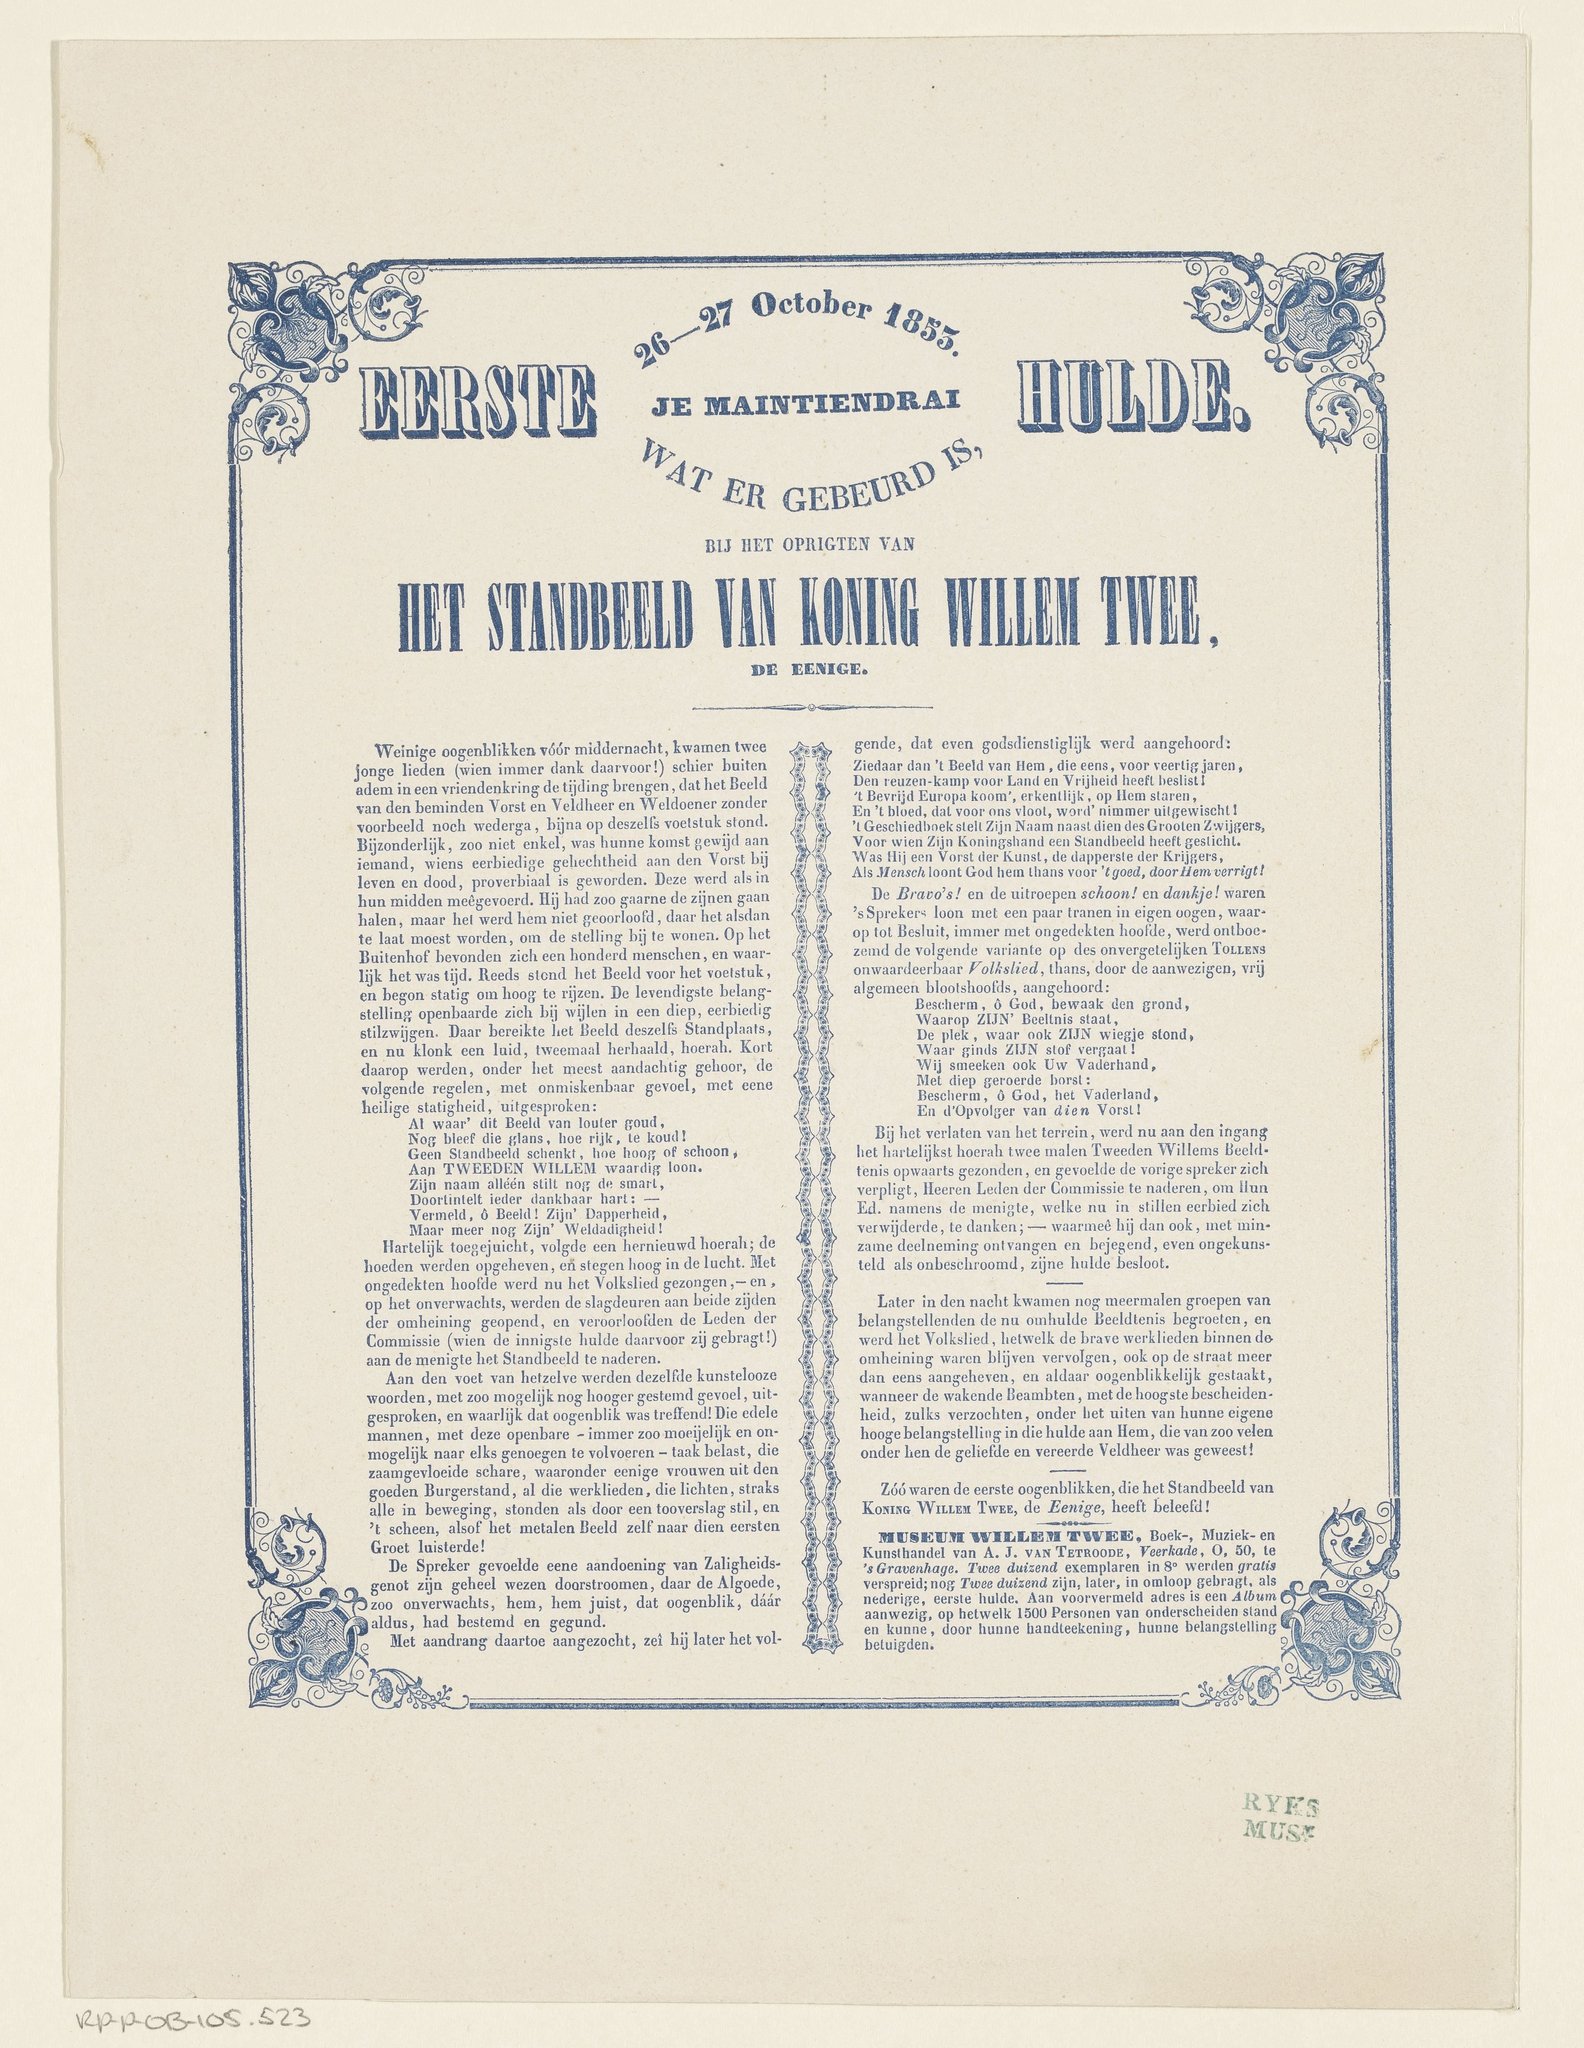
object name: text sheet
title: Eerste hulde aan het standbeeld van Willem II, koning der Nederlanden, op het Buitenhof te Den Haag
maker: anthonius johannes van tetroode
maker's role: printer, publisher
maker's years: 1795-1875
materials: paper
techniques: letterpress printing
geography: the hague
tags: the hague, william ii of the netherlands, monument, statue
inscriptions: collector's mark: Lugt 2165